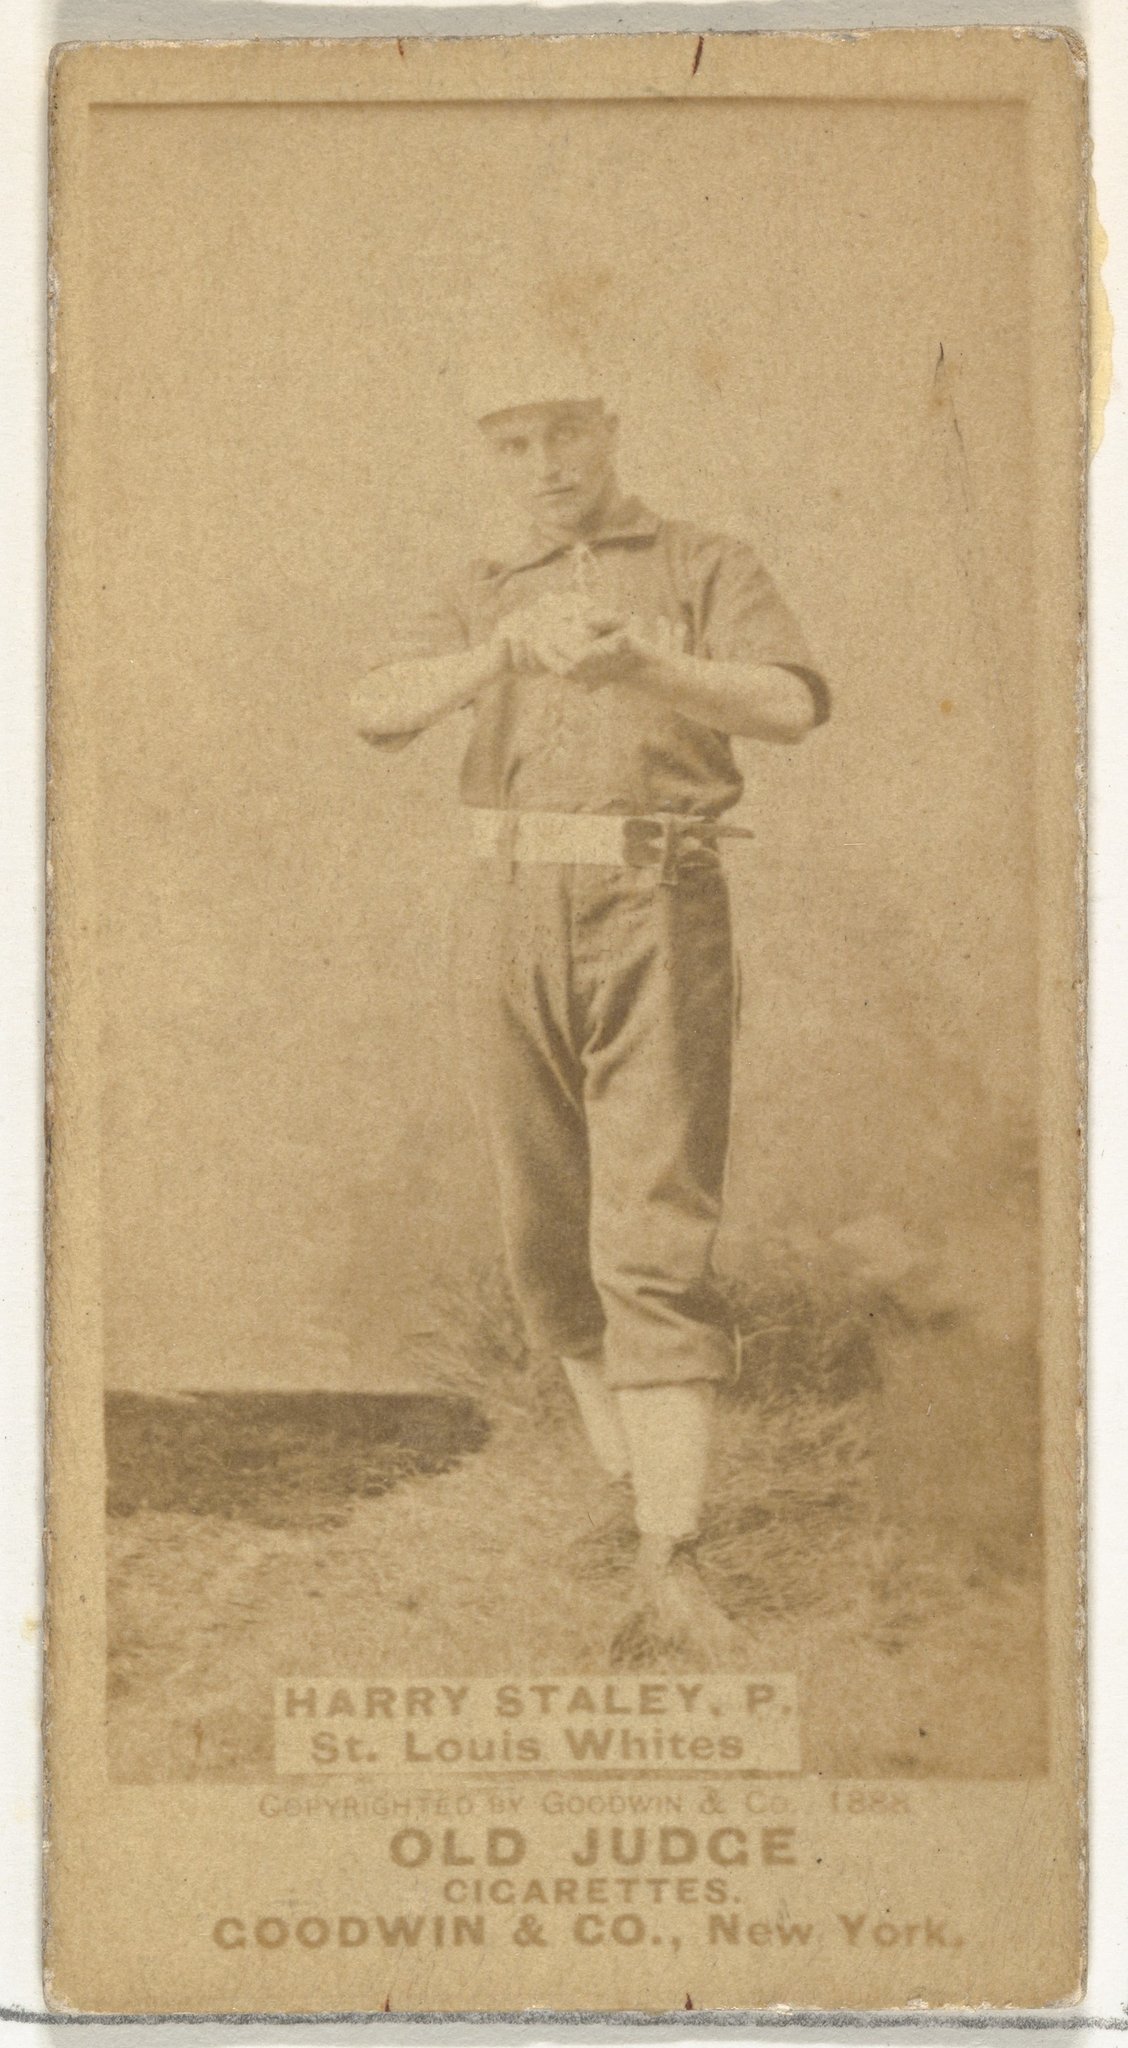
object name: baseball card, photograph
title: Staley, Pitcher, St. Louis Whites, from the Old Judge series (N172) for Old Judge Cigarettes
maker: goodwin & company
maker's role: publisher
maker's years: 1850-1950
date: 1888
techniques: albumen silver print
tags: men,portraits,baseball,athletes